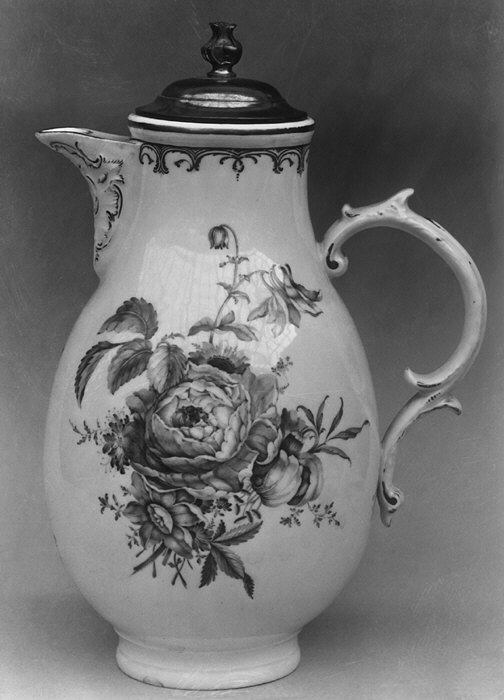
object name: coffeepot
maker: fürstenberg porcelain manufactory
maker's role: manufactory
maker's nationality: german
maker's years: 1747-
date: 1770-1775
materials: hard paste porcelain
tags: flowers